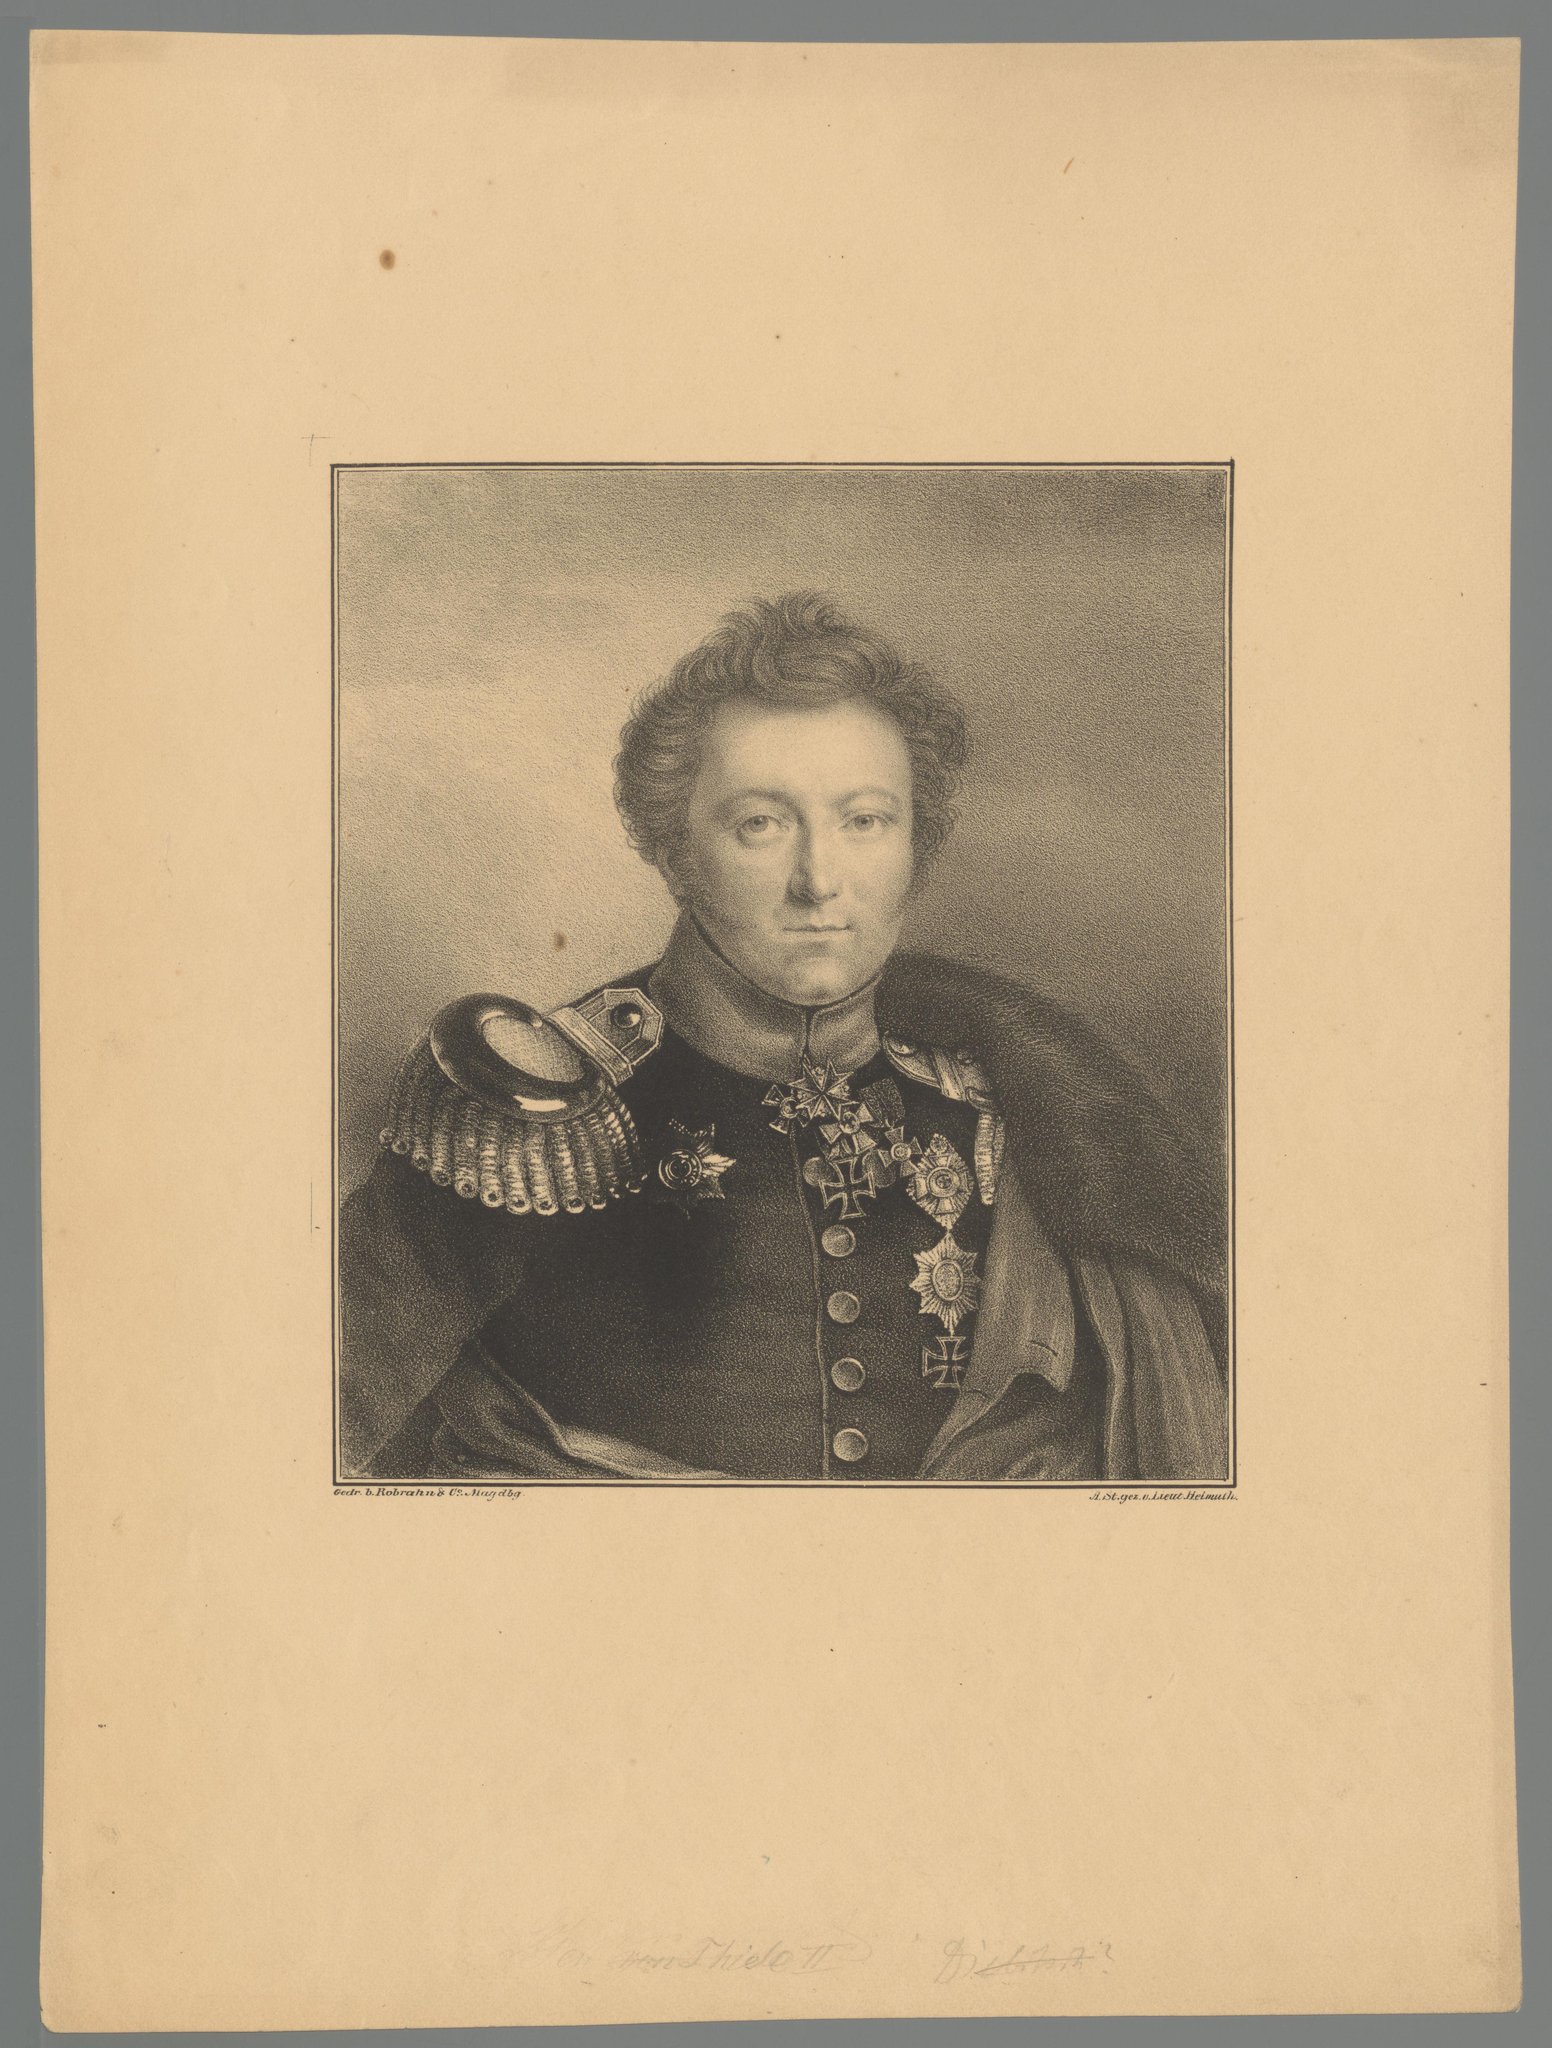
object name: print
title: Portret van Ludwig Gustav von Thiele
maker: helmuth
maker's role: print maker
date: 1810-1830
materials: paper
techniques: lithograph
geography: magdeburg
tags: politician, commander-in-chief, general, marshal, historical persons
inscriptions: collector's mark: Lugt 2228